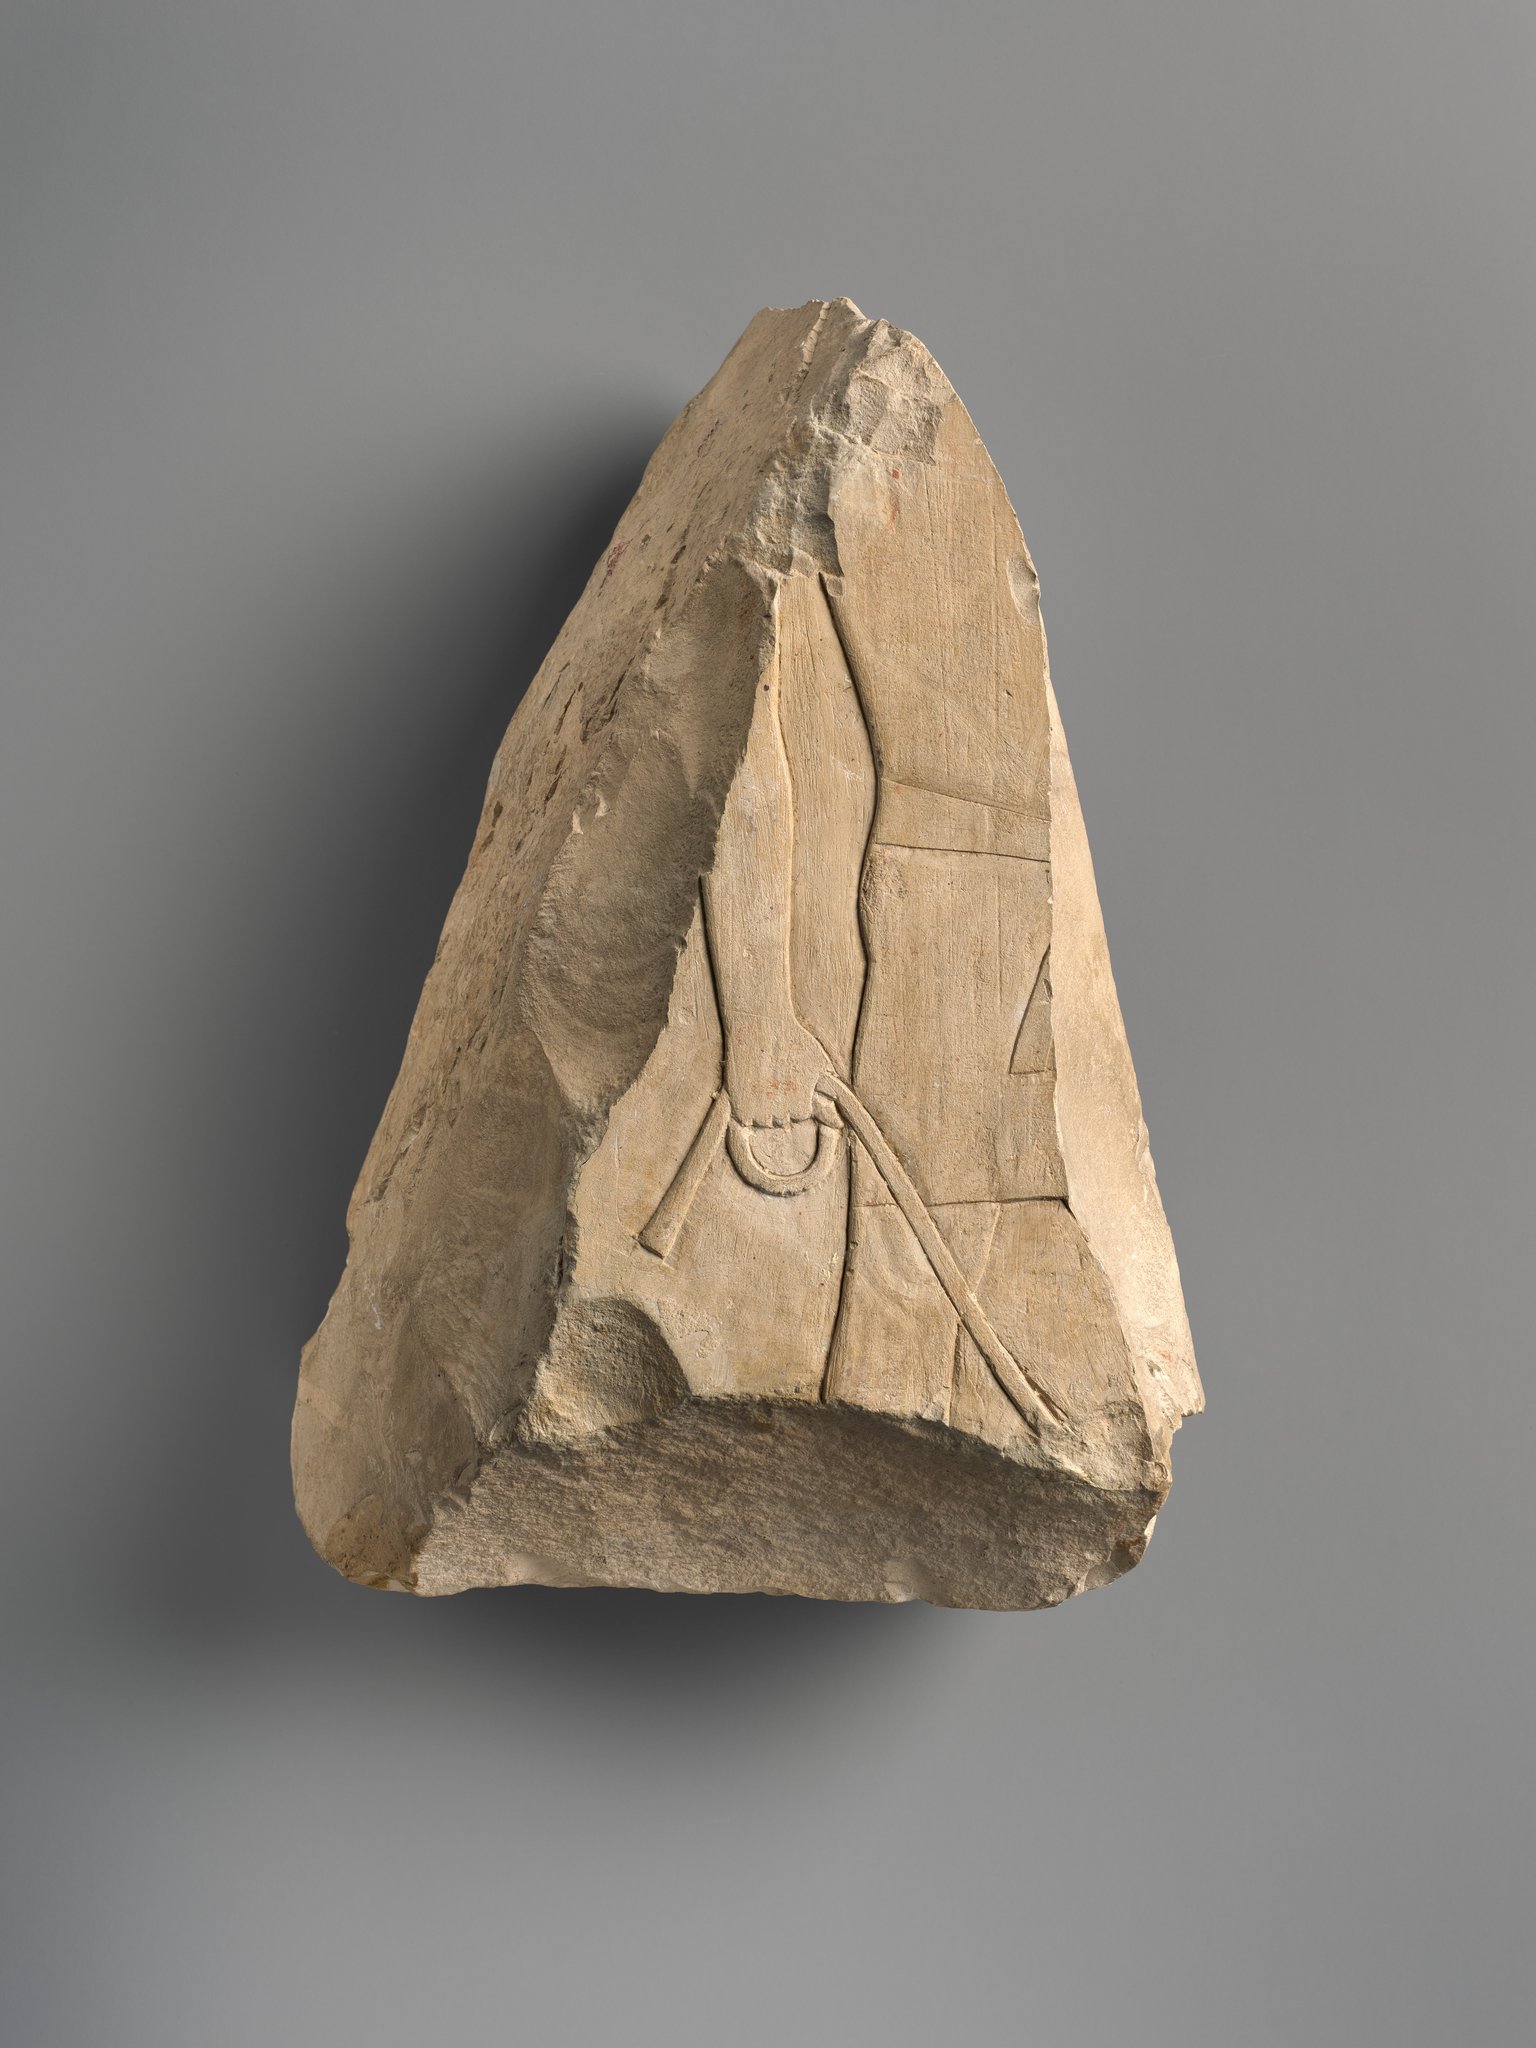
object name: relief, tomb of nespekashuty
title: Raised relief fragment of a man bringing a leashed animal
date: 664-610 BCE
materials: limestone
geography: egypt